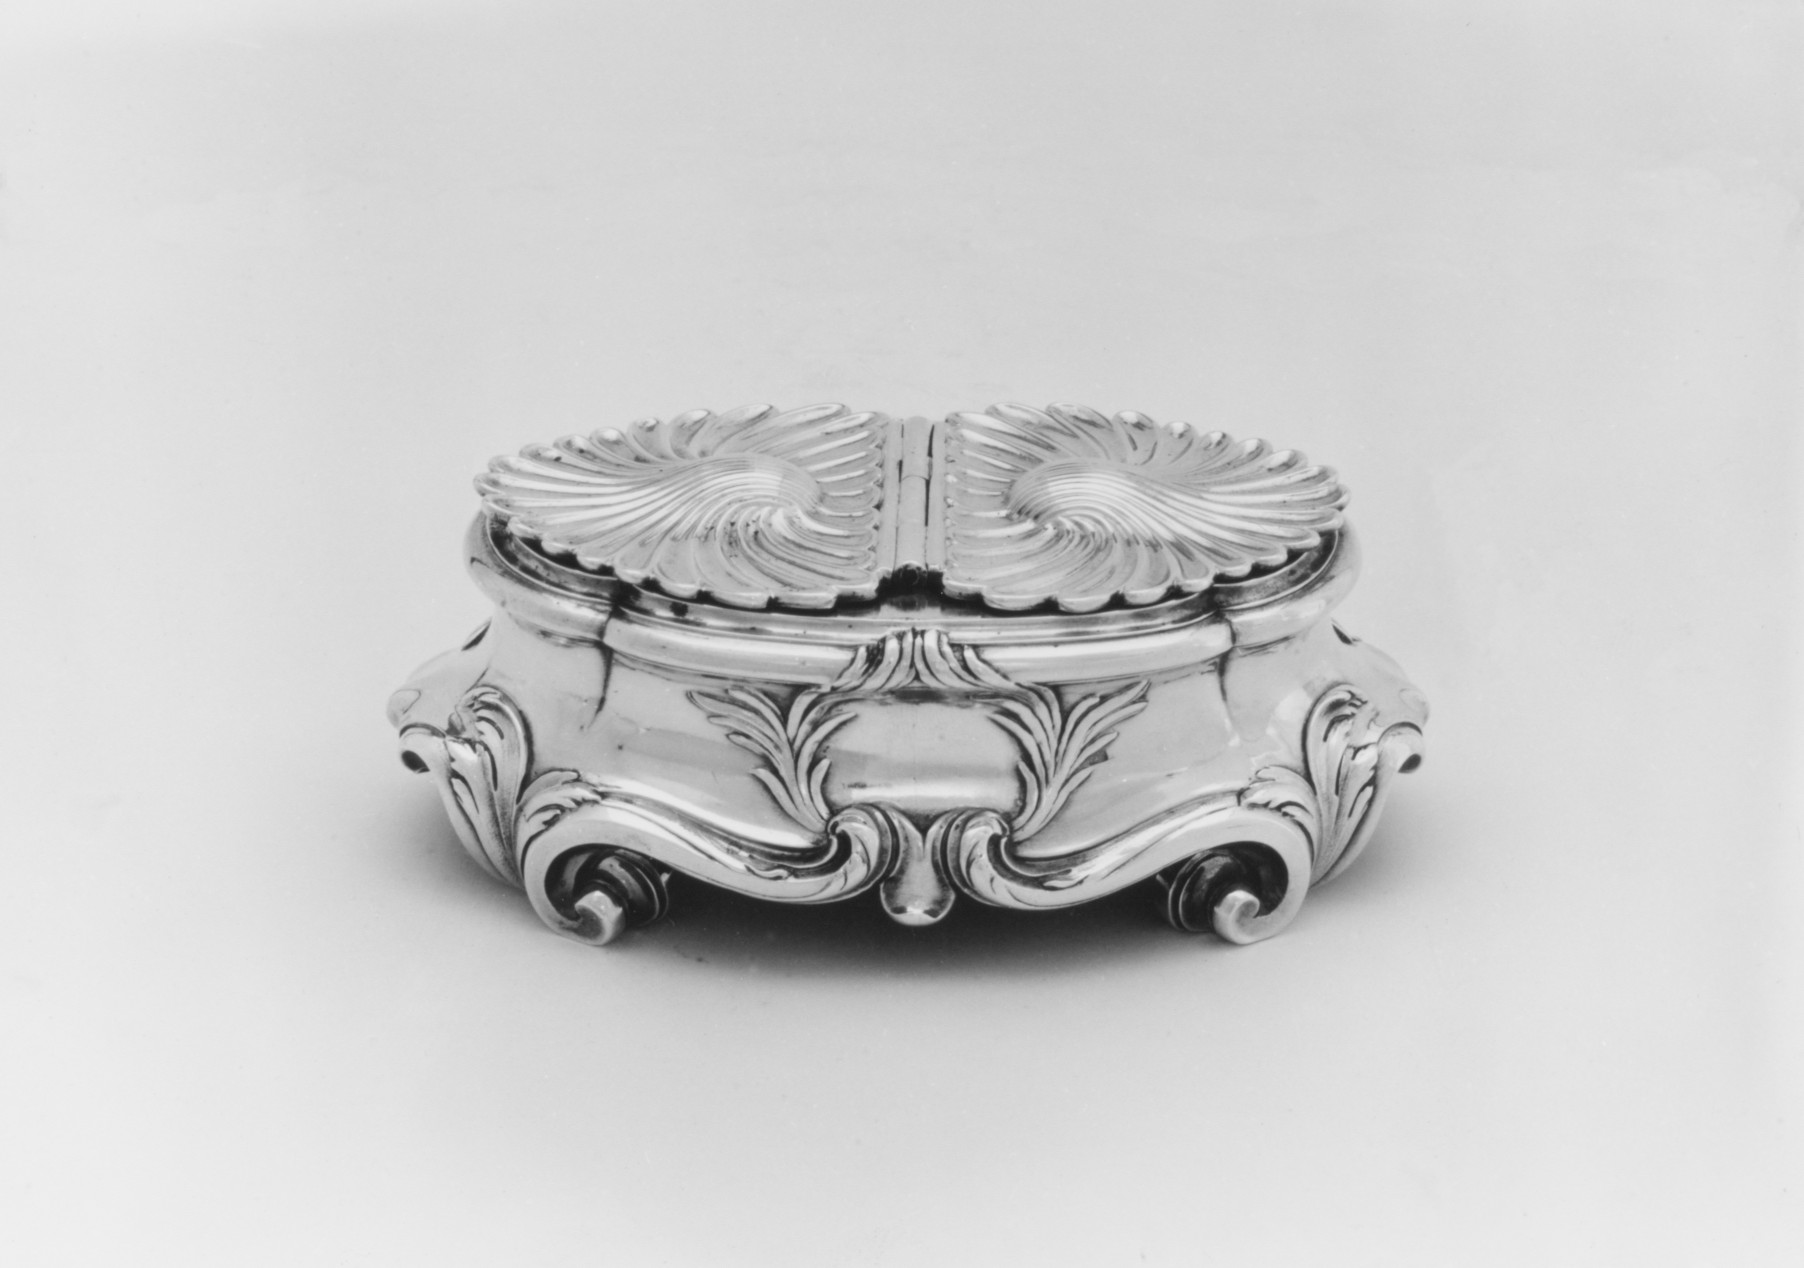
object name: double salt or pepper box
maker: pierre-aymé joubert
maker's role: maker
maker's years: 1705-1789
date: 1748-1749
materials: silver